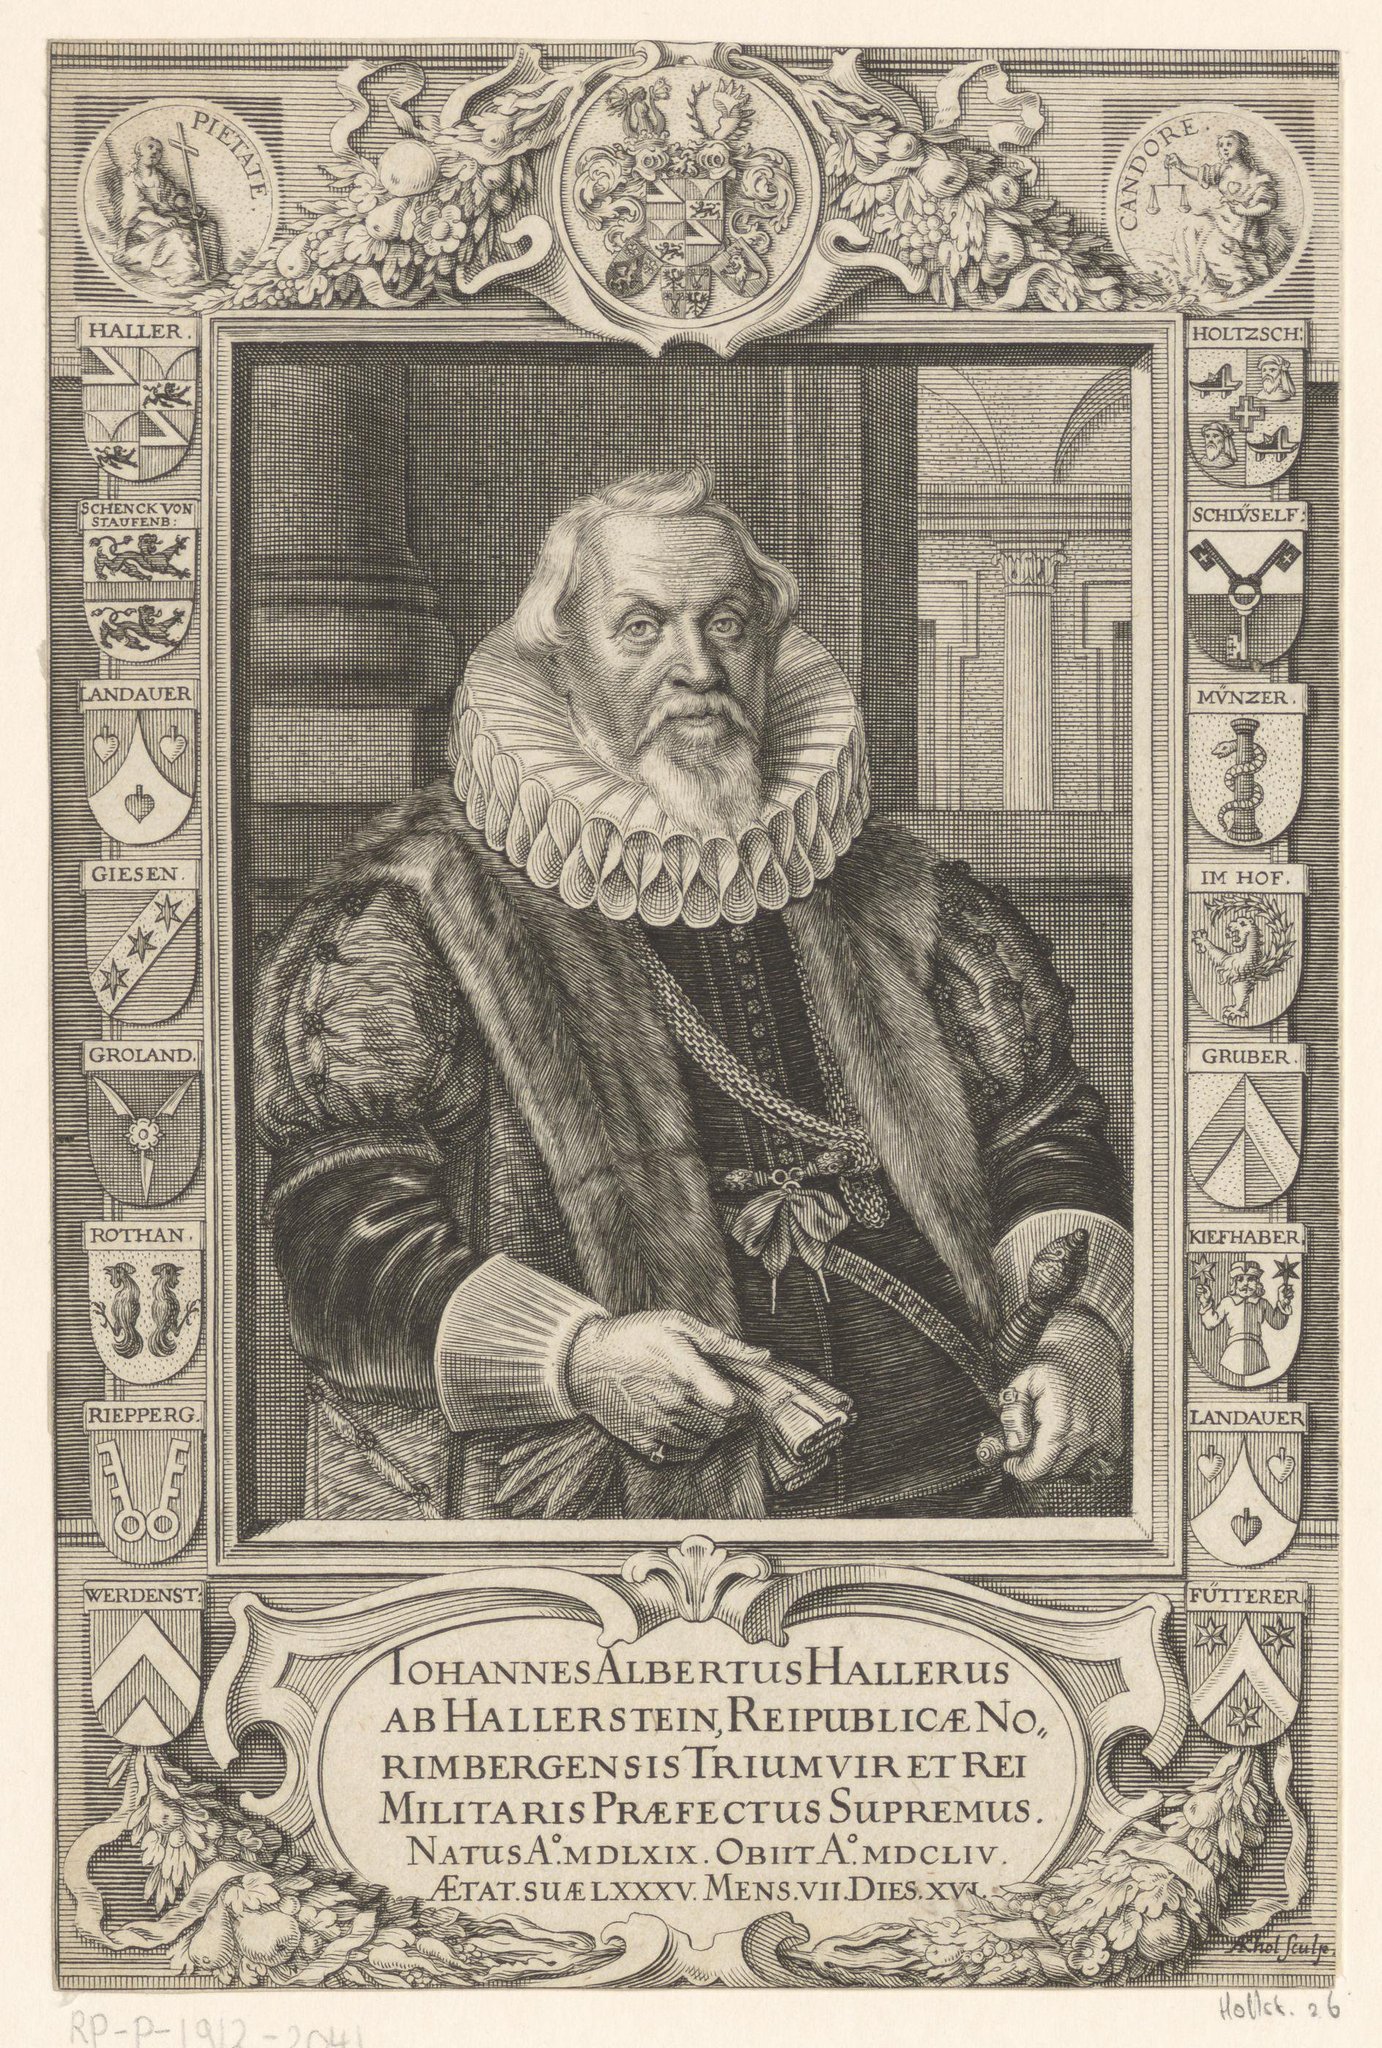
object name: print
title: Portret van Johann Albrecht Haller von Hallerstein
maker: andreas kohl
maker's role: print maker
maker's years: 1624-1657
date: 1654-1657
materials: paper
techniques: engraving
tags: coat of arms (as symbol of the state, etc.), gloves, mittens, etc., historical persons, counsellor, ornament ~ festoon, garland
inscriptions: collector's mark: Lugt 2228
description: Tekst in het Latijn in de cartouche en wapenschilden als omlijsting.